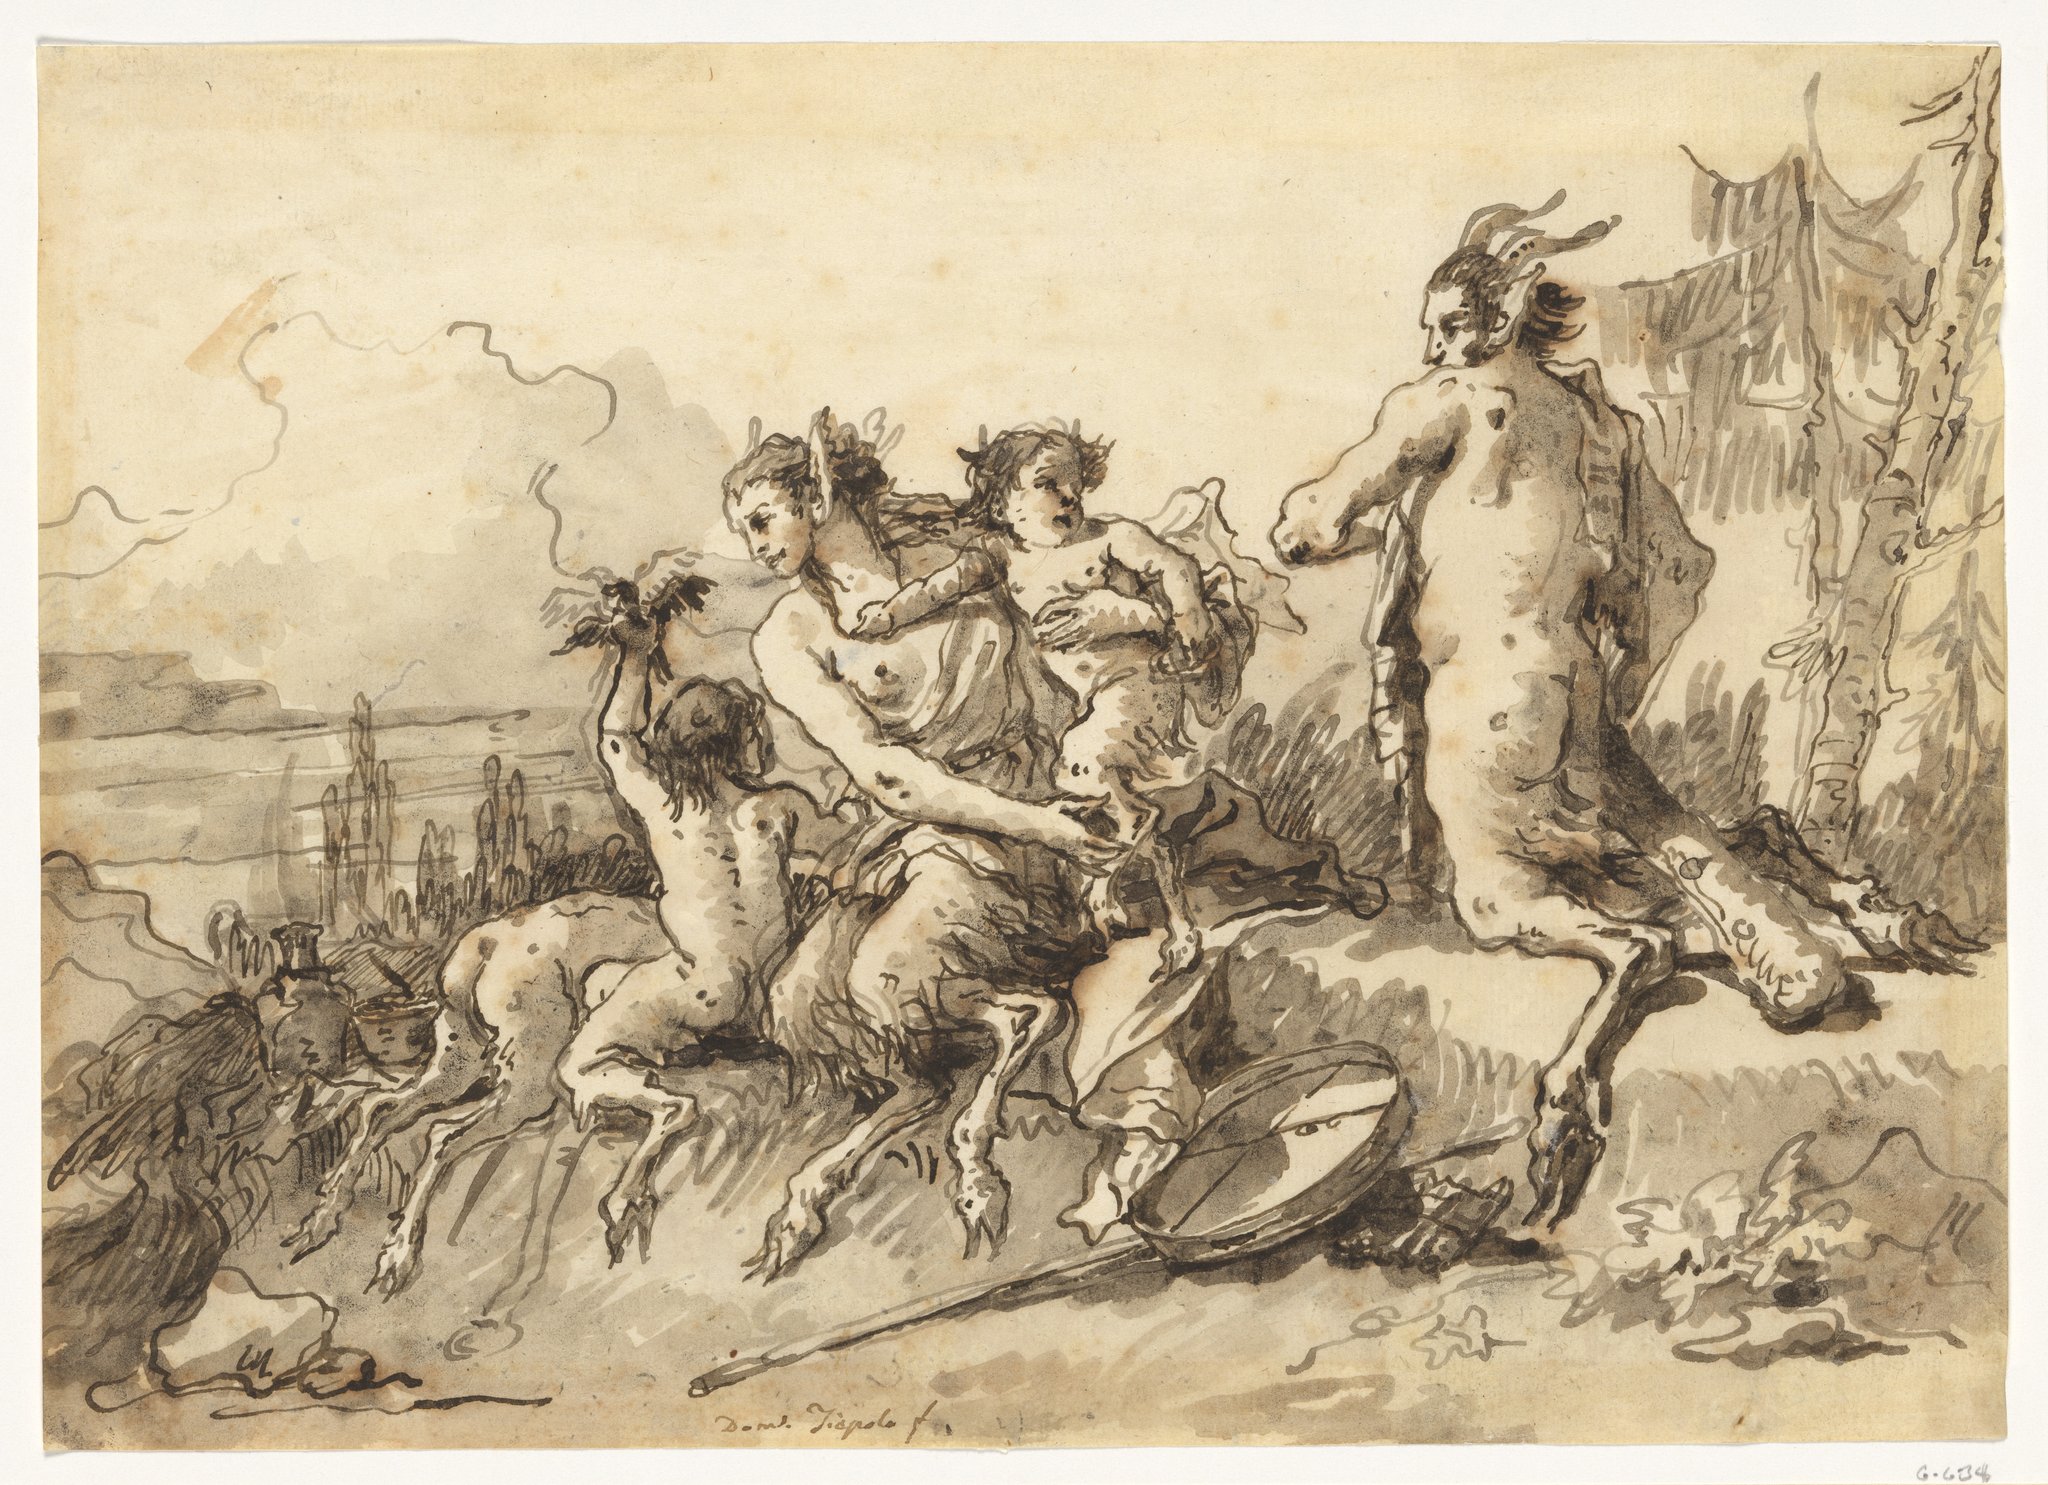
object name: drawing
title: Satyr Family in a Wild Landscape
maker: giovanni domenico tiepolo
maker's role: artist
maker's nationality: italian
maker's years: 1727-1804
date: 1771-1791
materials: ink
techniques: pen, wash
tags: satyrs,family